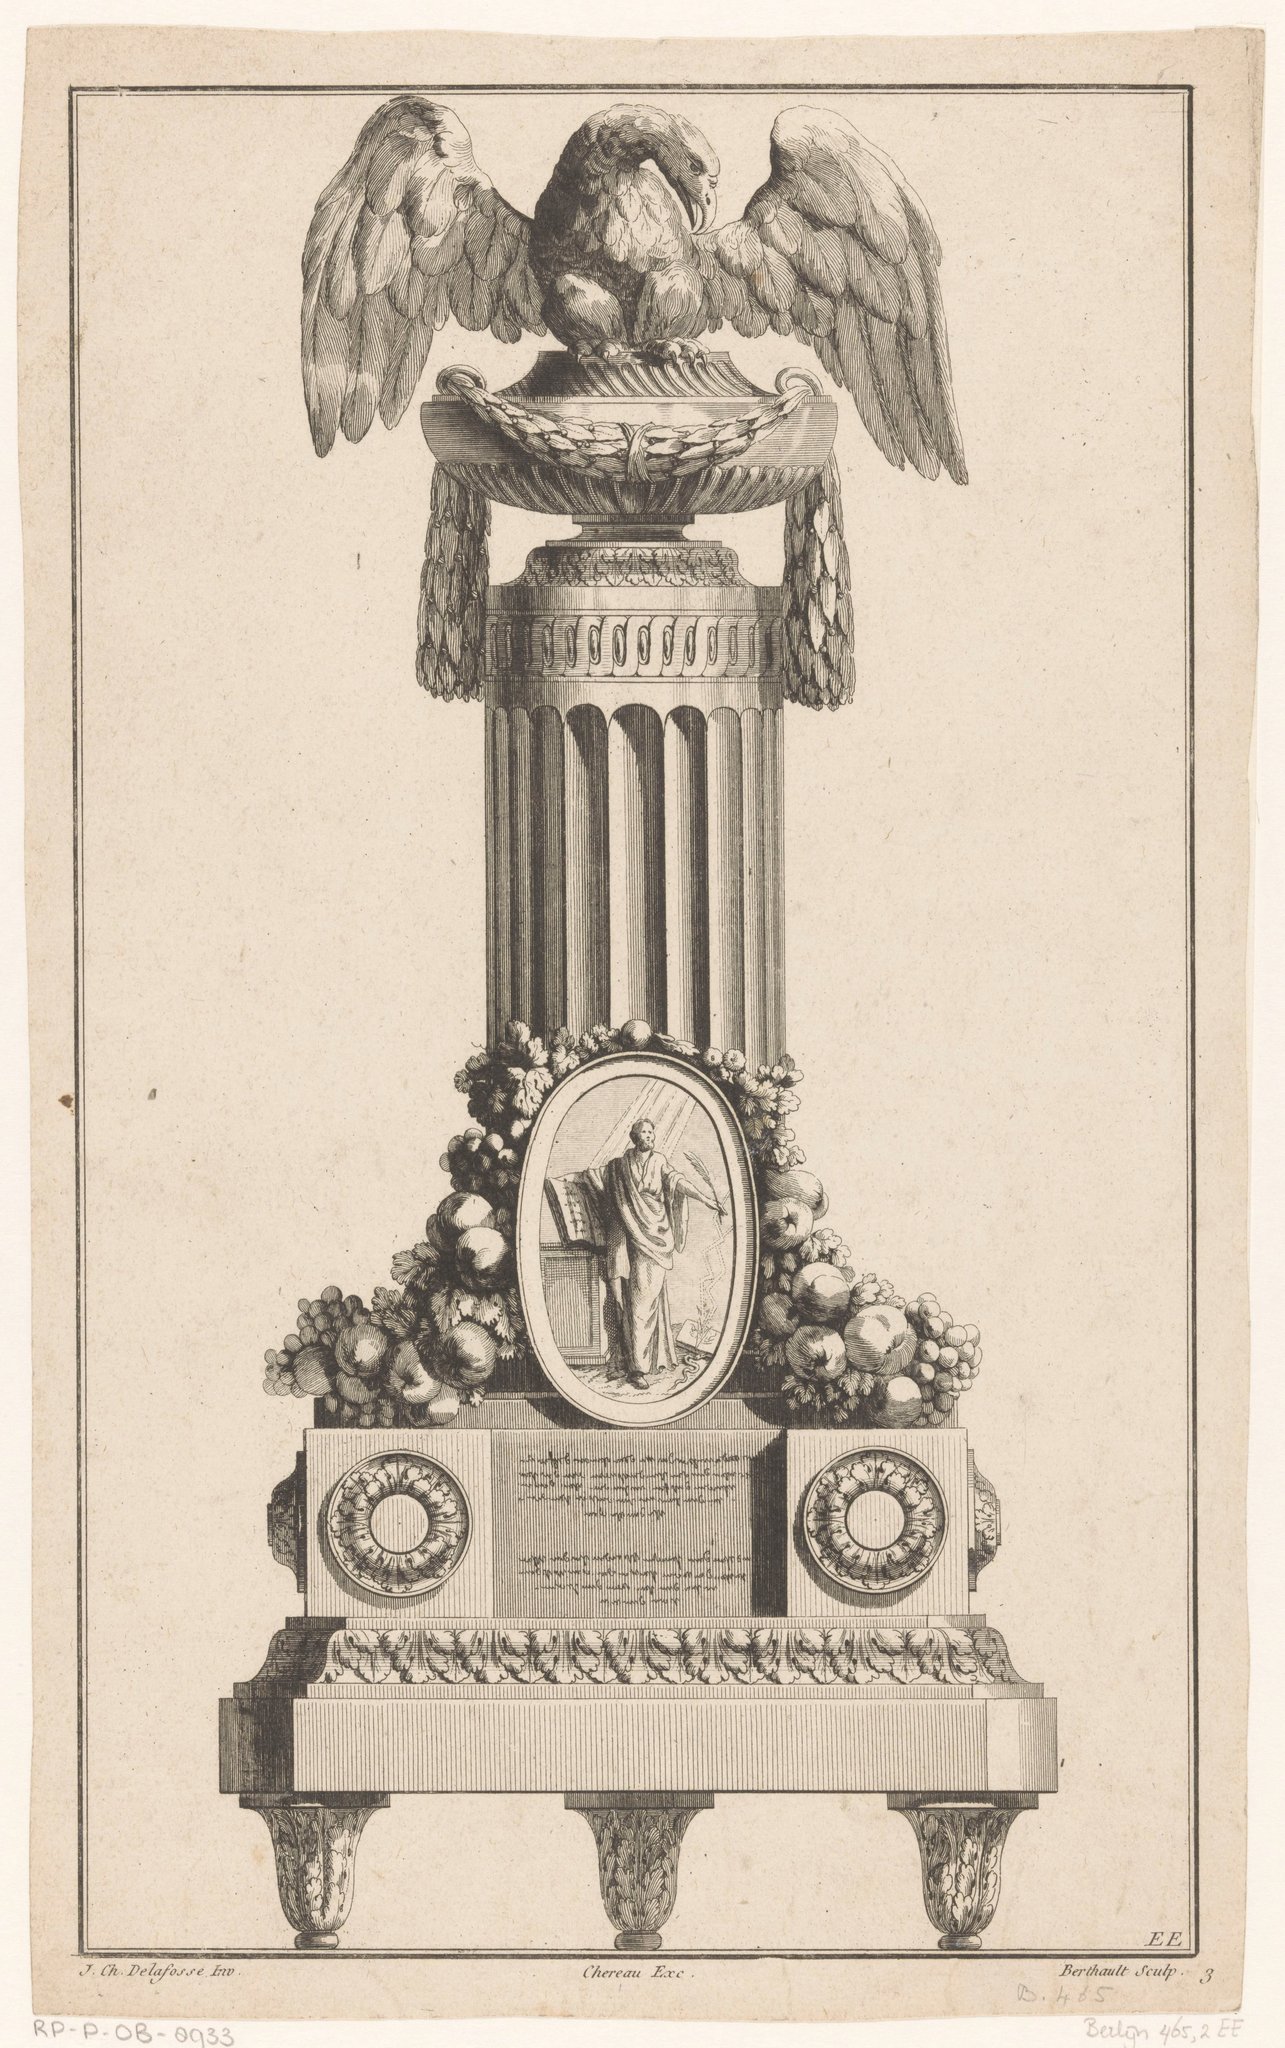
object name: print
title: IIe Volume De l'Oeuvre de J. Ch. Delafosse (...)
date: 1771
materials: paper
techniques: engraving, etching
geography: paris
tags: lectern, predatory birds: eagle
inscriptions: collector's mark: Lugt 2228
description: Een geornamenteerde lessenaar met een adelaar op een vaas, aan de onderzijde een ovaal medaillon met een staande man met boek, veer en bliksemschichten.